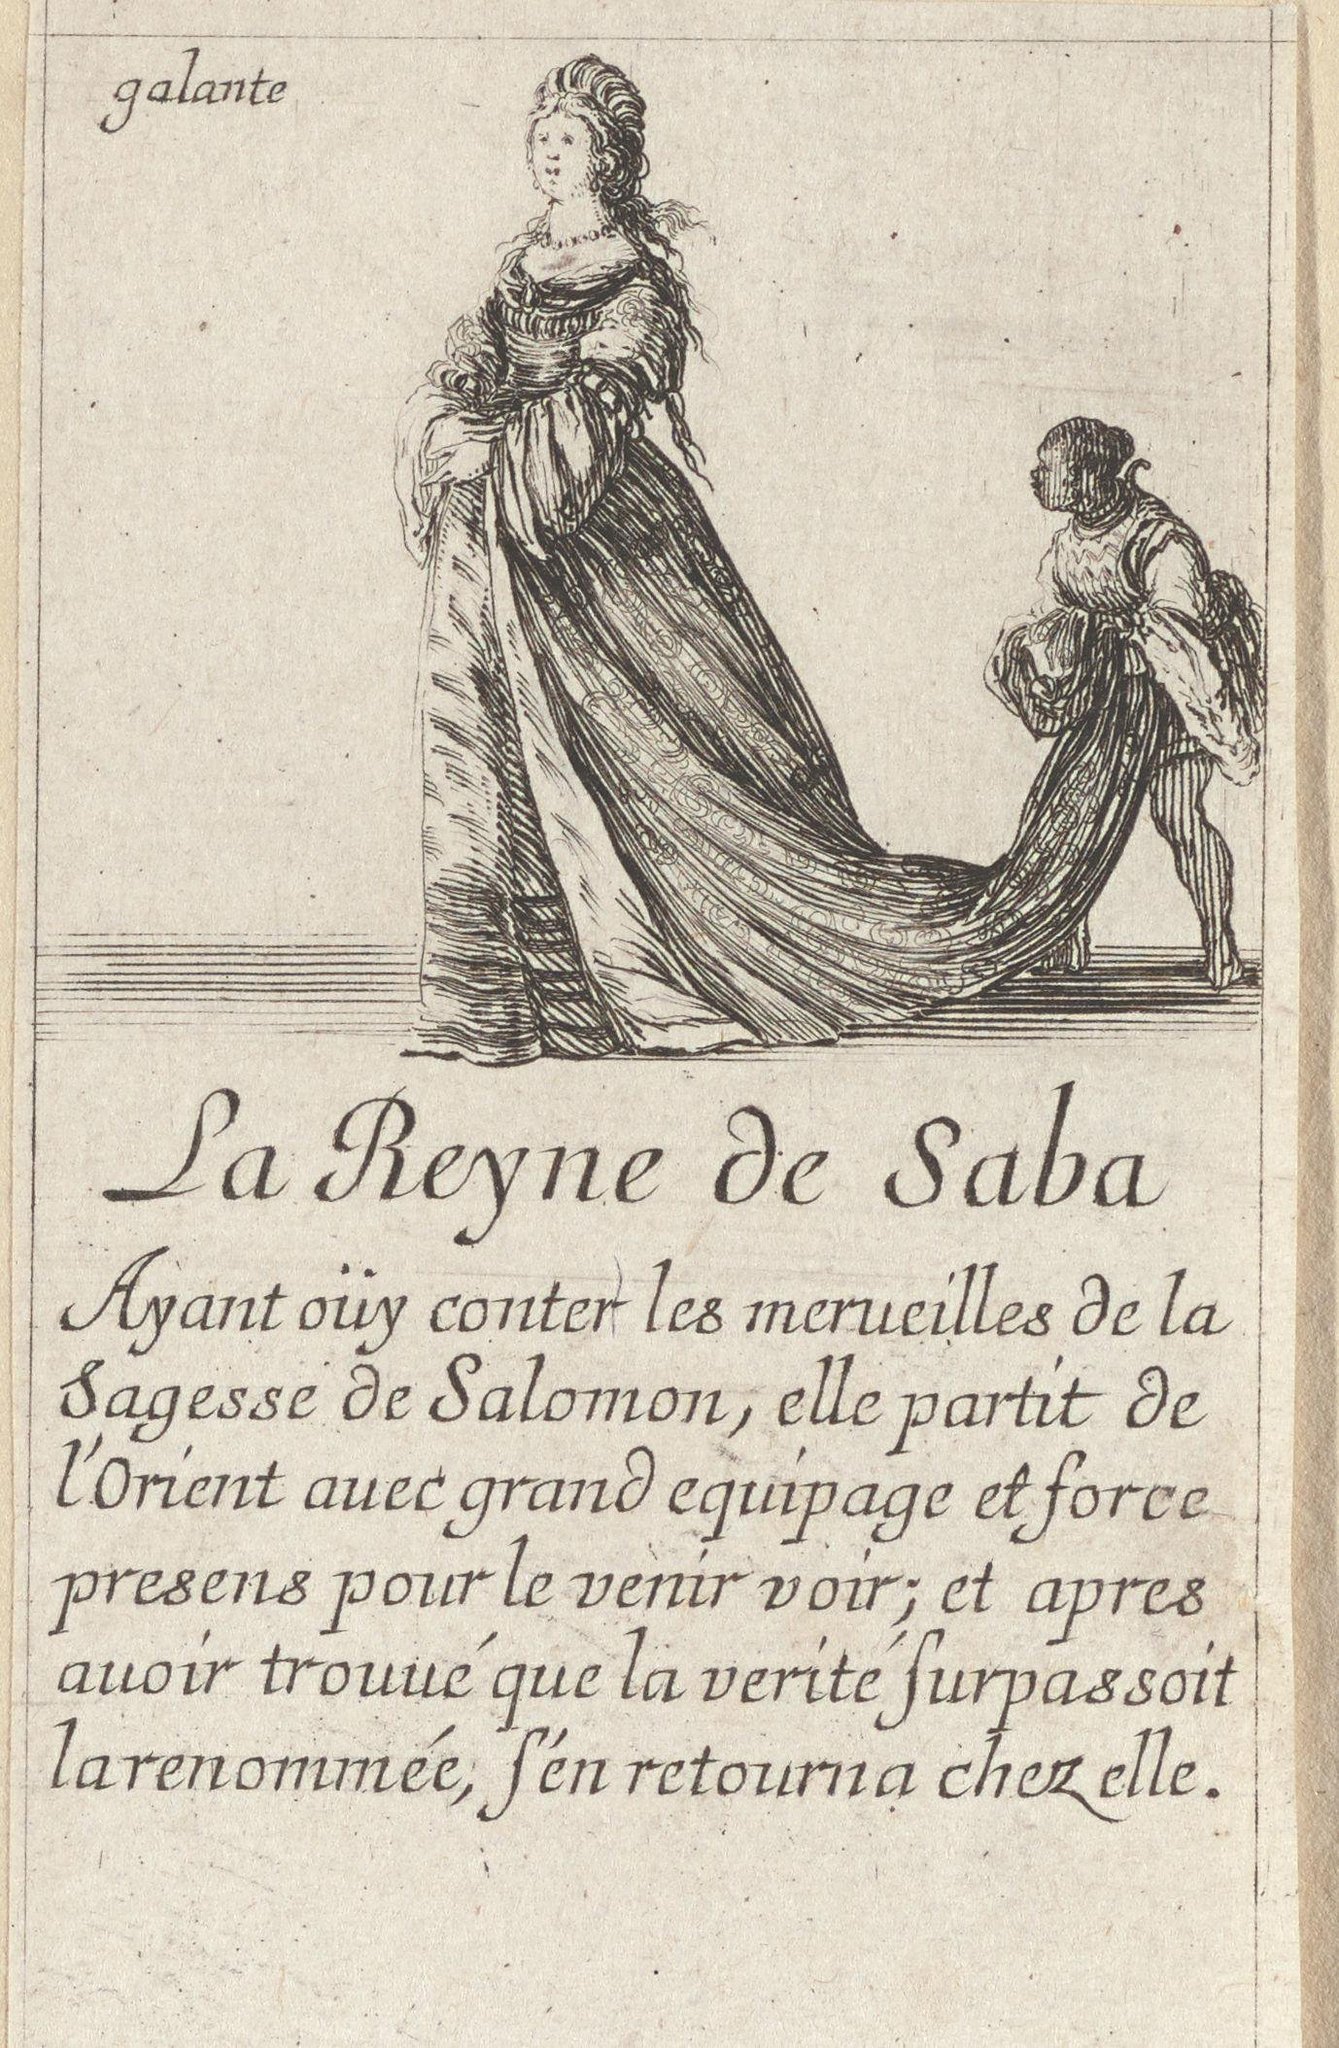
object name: playing card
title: Kaartspel met gerenommeerde heerseressen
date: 1620-1664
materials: paper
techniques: etching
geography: paris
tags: ruler, sovereign - bb - female ruler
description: Deze prent maakt deel uit van een kaartspel met 52 kaarten met voorstellingen van beroemde koninginnen. De serie is uitgedacht door Jean Desmarests de Saint-Sorlin in opdracht van Kardinaal Mazarin. Het kaartspel werd gemaakt voor de jonge Lodewijk XIV, samen met het Jeu des Fables, Jeu de la Géographie en Jeu des Rois de France.